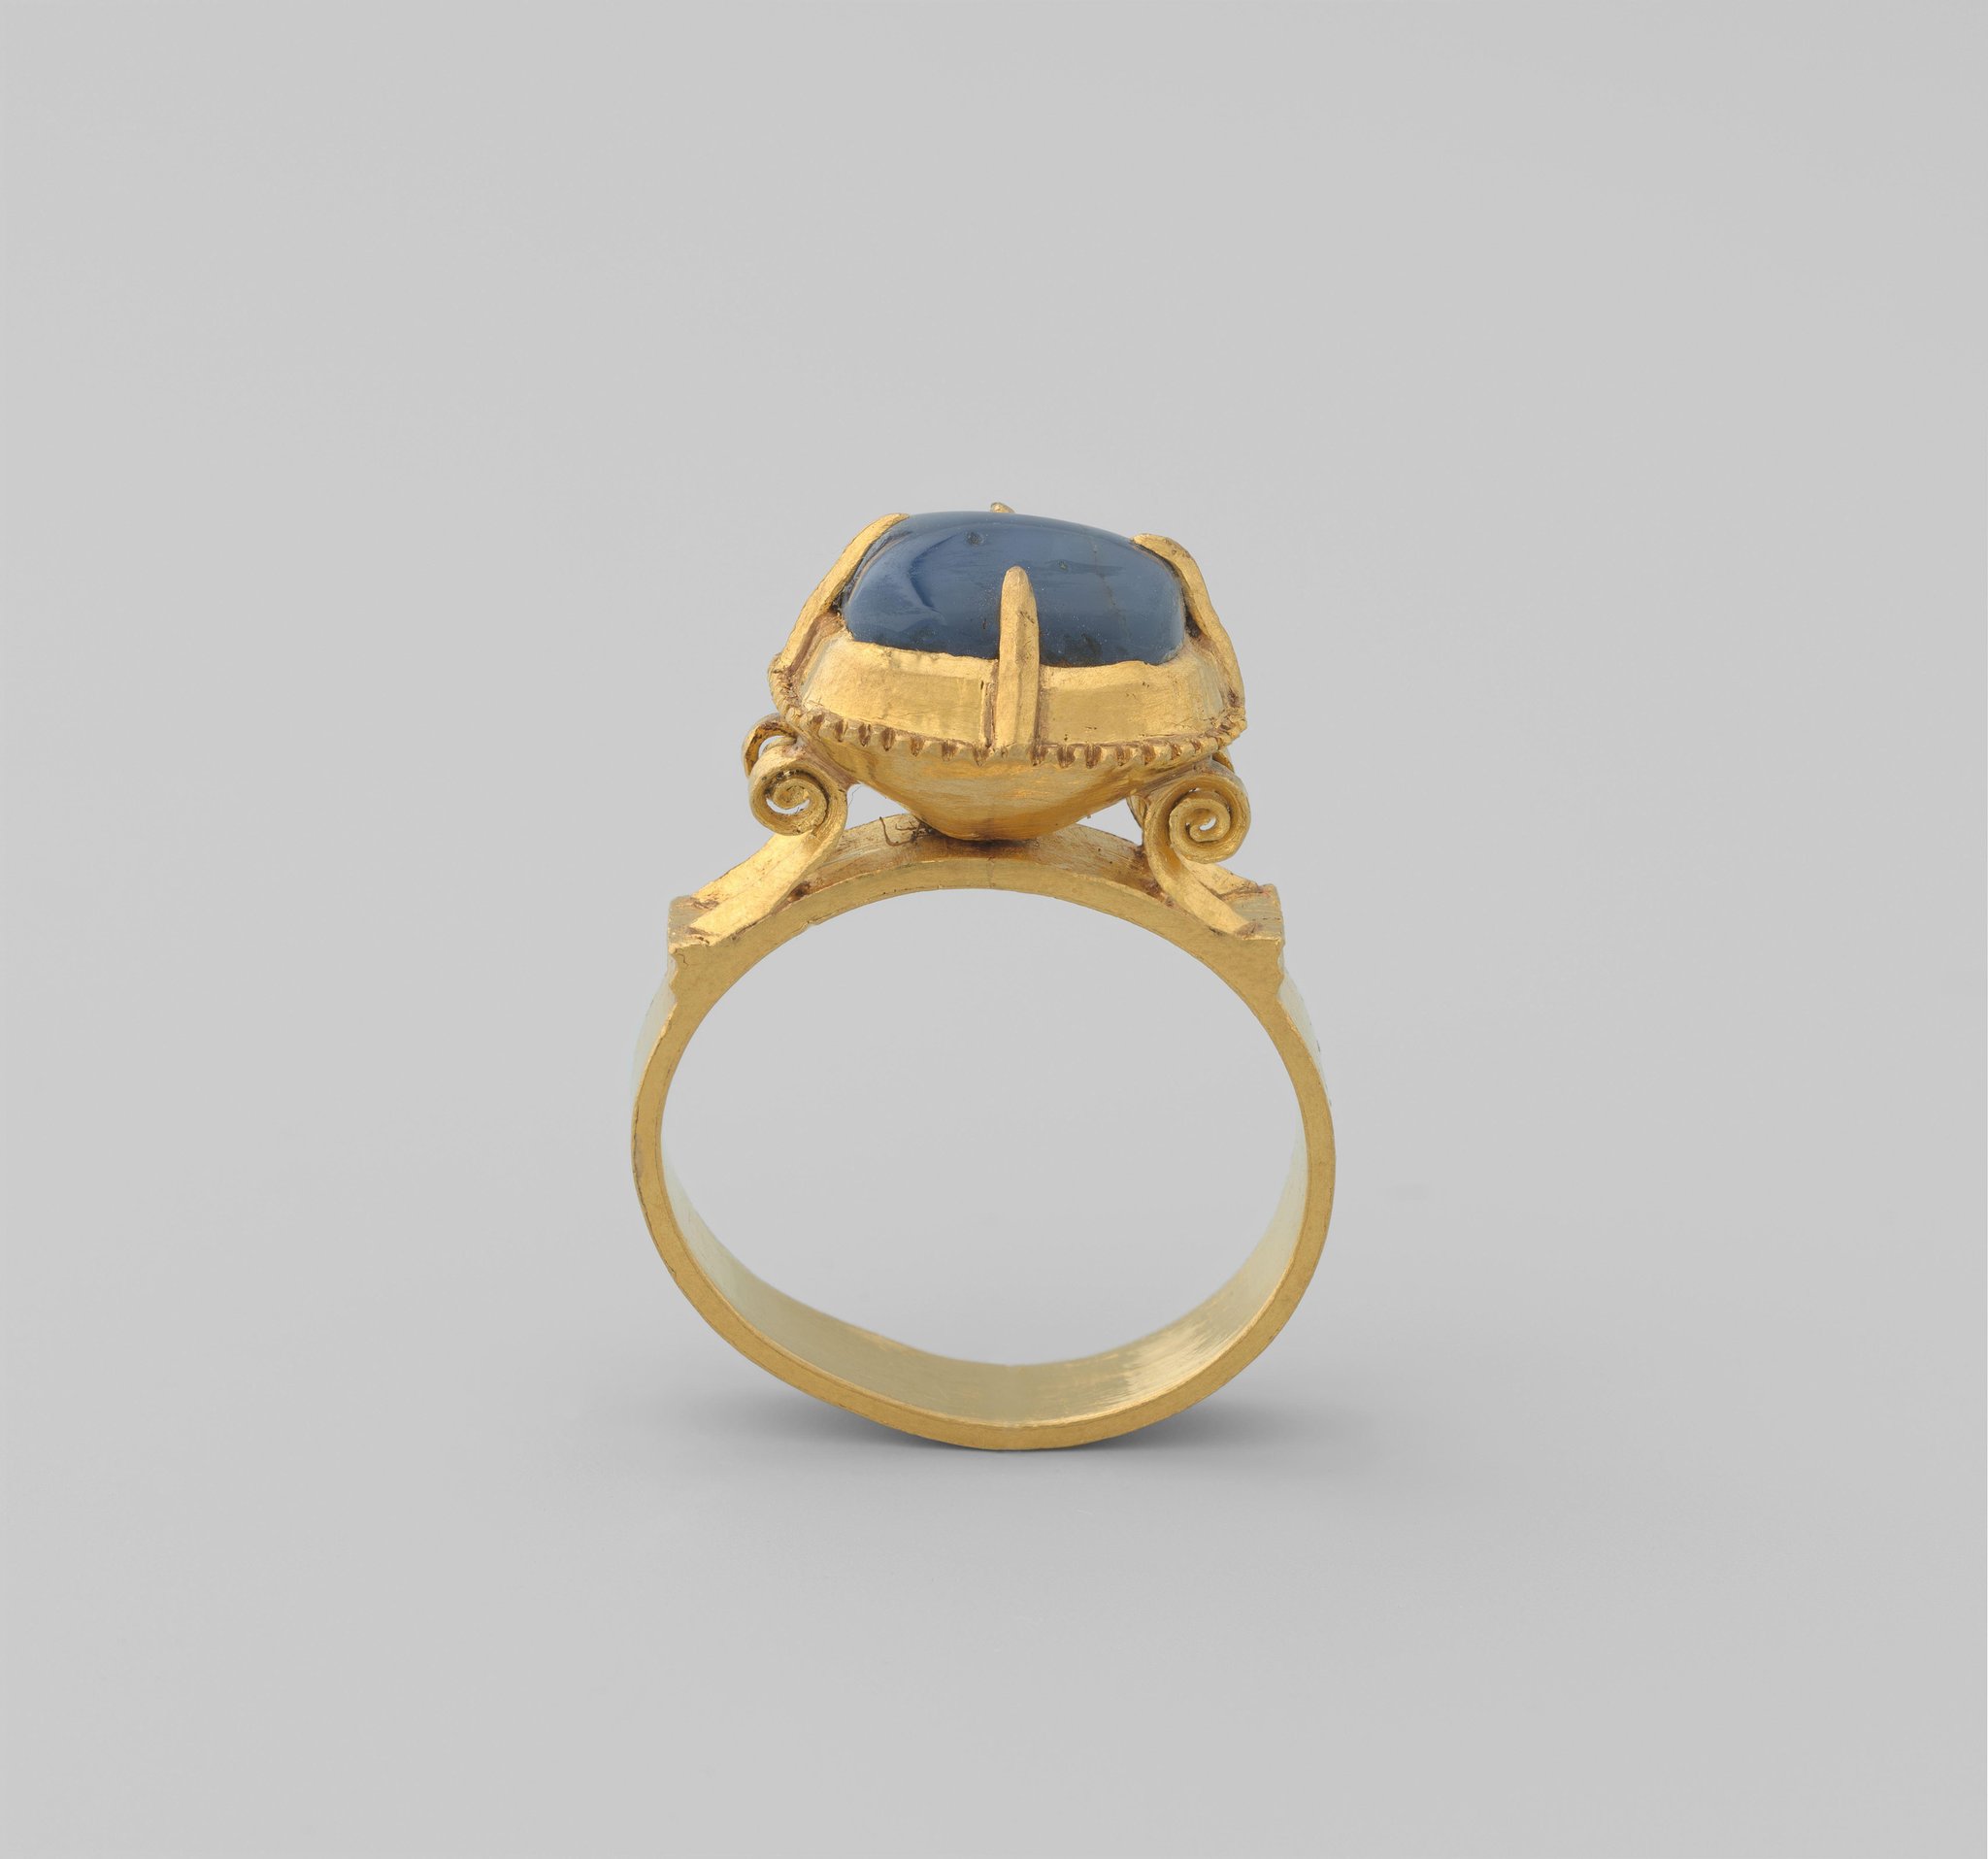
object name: ring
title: Ring for a bishop or a cardinal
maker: Anonymous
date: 1350-1450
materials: gold, gemstone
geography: utrecht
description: Ring van goud met een troebele saffier in een klauwzetting. De schouders van de ring zijn tegen de zetkast aan versierd met voluten.